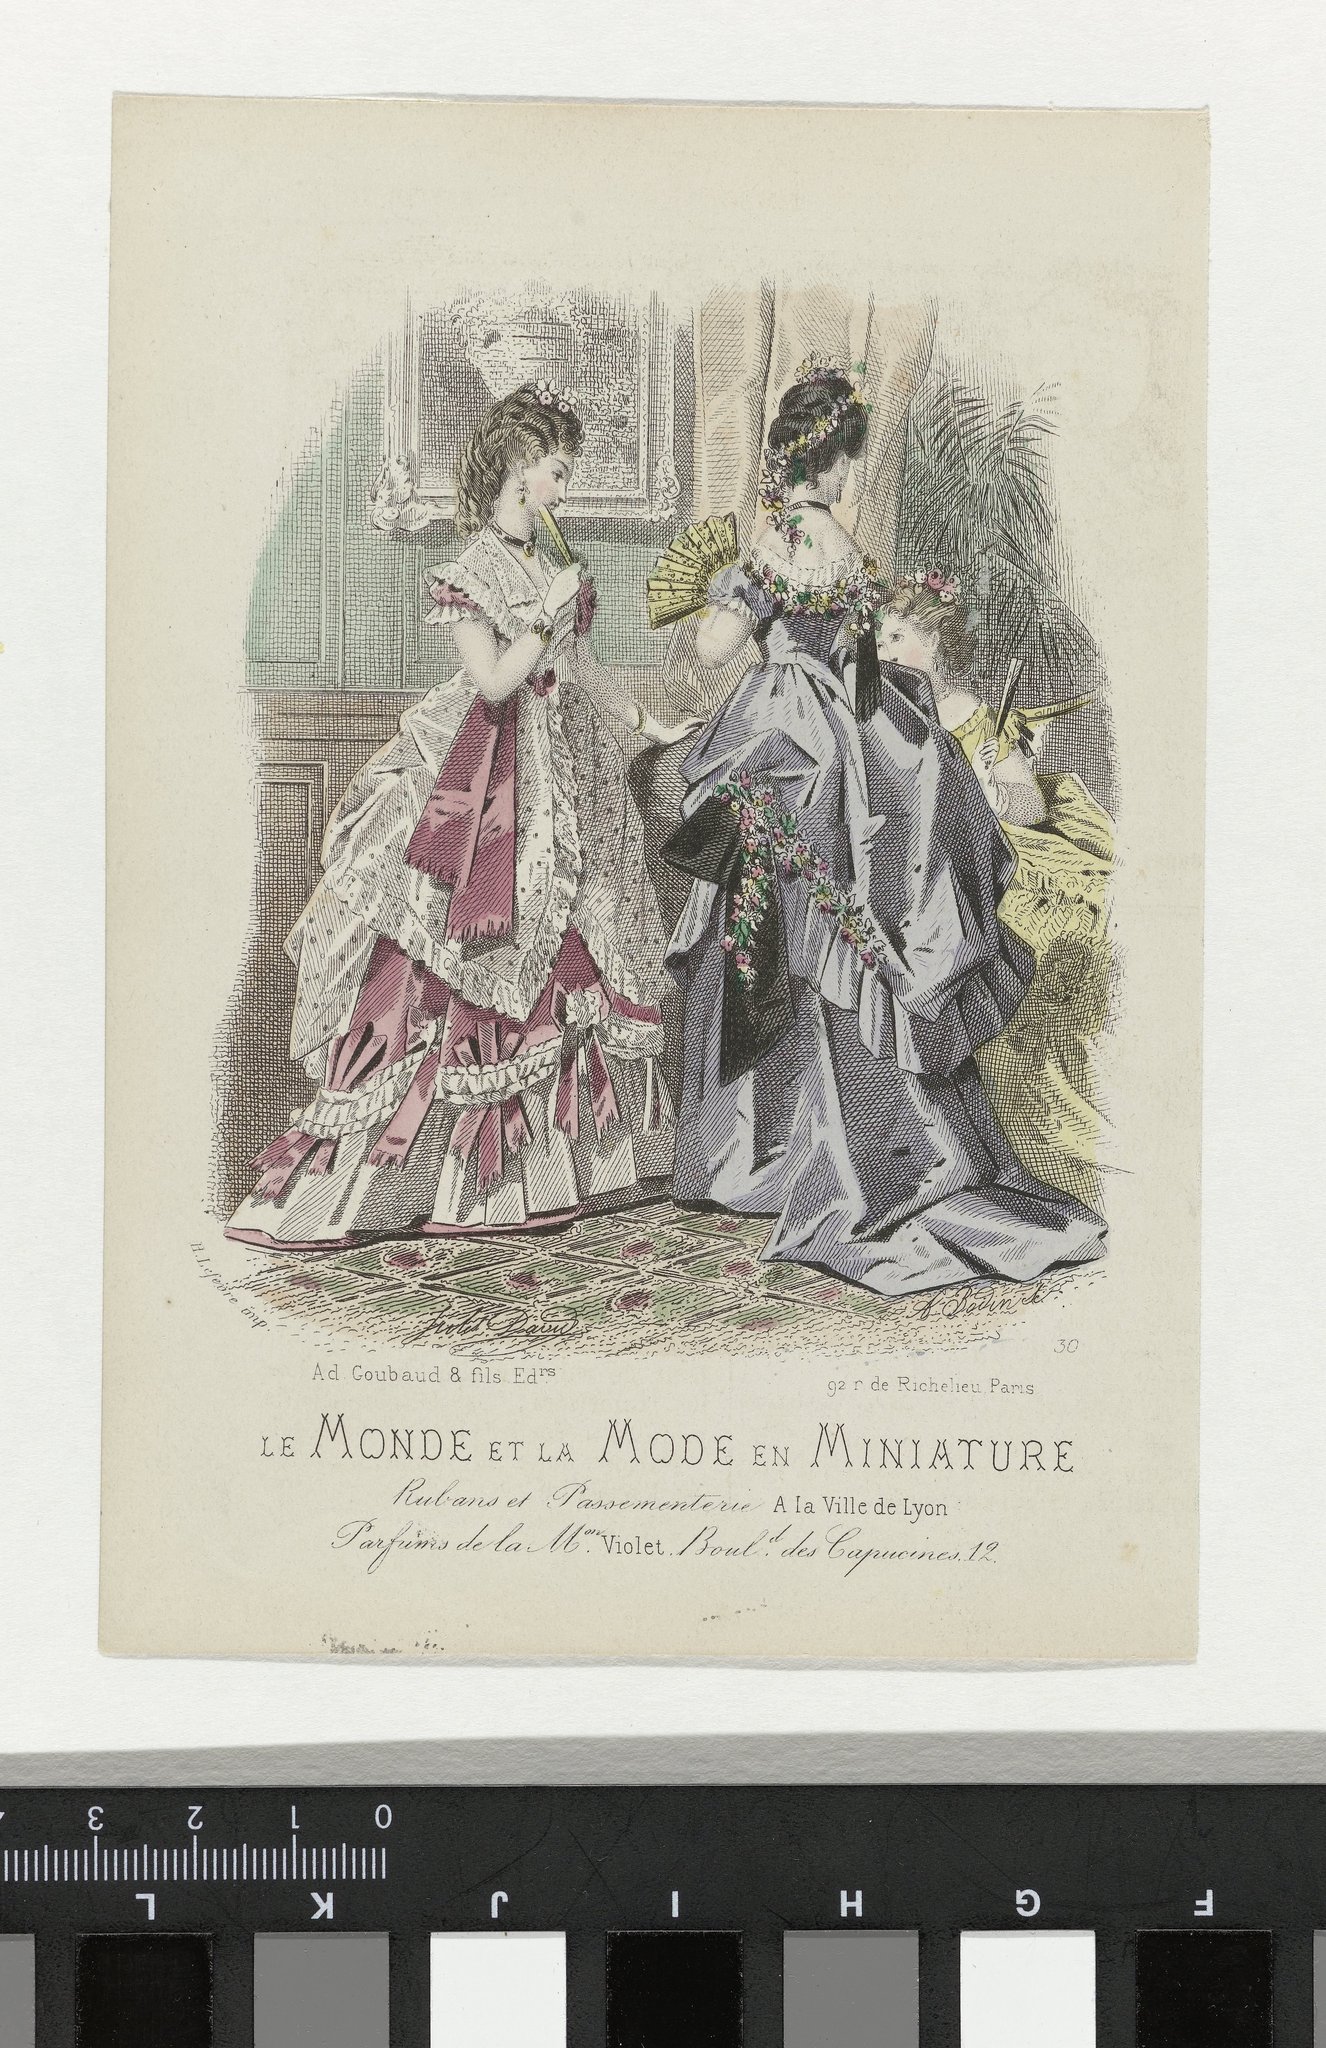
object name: fashion print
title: Le Monde et la Mode en Miniature, 1873, No. 30 : Rubans et Passementeri (...)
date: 1873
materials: paper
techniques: engraving, hand coloring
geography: paris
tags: flowers, ear-rings (+ women's clothes), ornamental parts of clothing (+ women's clothes), border, ribbon, braid (+ women's clothes), fashion plates, skirt (+ women's clothes), dress, gown (+ women's clothes), bracelet, wristlet (+ women's clothes), necklace (+ women's clothes)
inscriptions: caption: ‘Rubans et Passementerie A la Ville de Lyon Parfums de la Mon Violet Bould des Capucines 12’, title: ‘Le Monde et la Mode en Miniature / Magasin - Bijou Illustré’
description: Drie vrouwen in interieur. De linkervrouw is gekleed in een japon van roze faille met tournureDe rok is aan de onderkant versierd met een volant van geplooide witte 'tarlatane'. De middelste vrouw draagt een rok van effen paarse 'pou-de-soie' met tournure en een 'Tunique' van 'gaze de Chambéry' in dezelfde tint, opgehouden aan twee kanten. Onder de voorstelling volgen enkele regels reclametekst voor verschillende producten. Prent uit het modetijdschrift La Mode Miniature (1872-1873). De prent is een kopie naar 1069B uit het modetijdschrift 'Le Journal des Dames et des Demoiselles' (1841-1902).